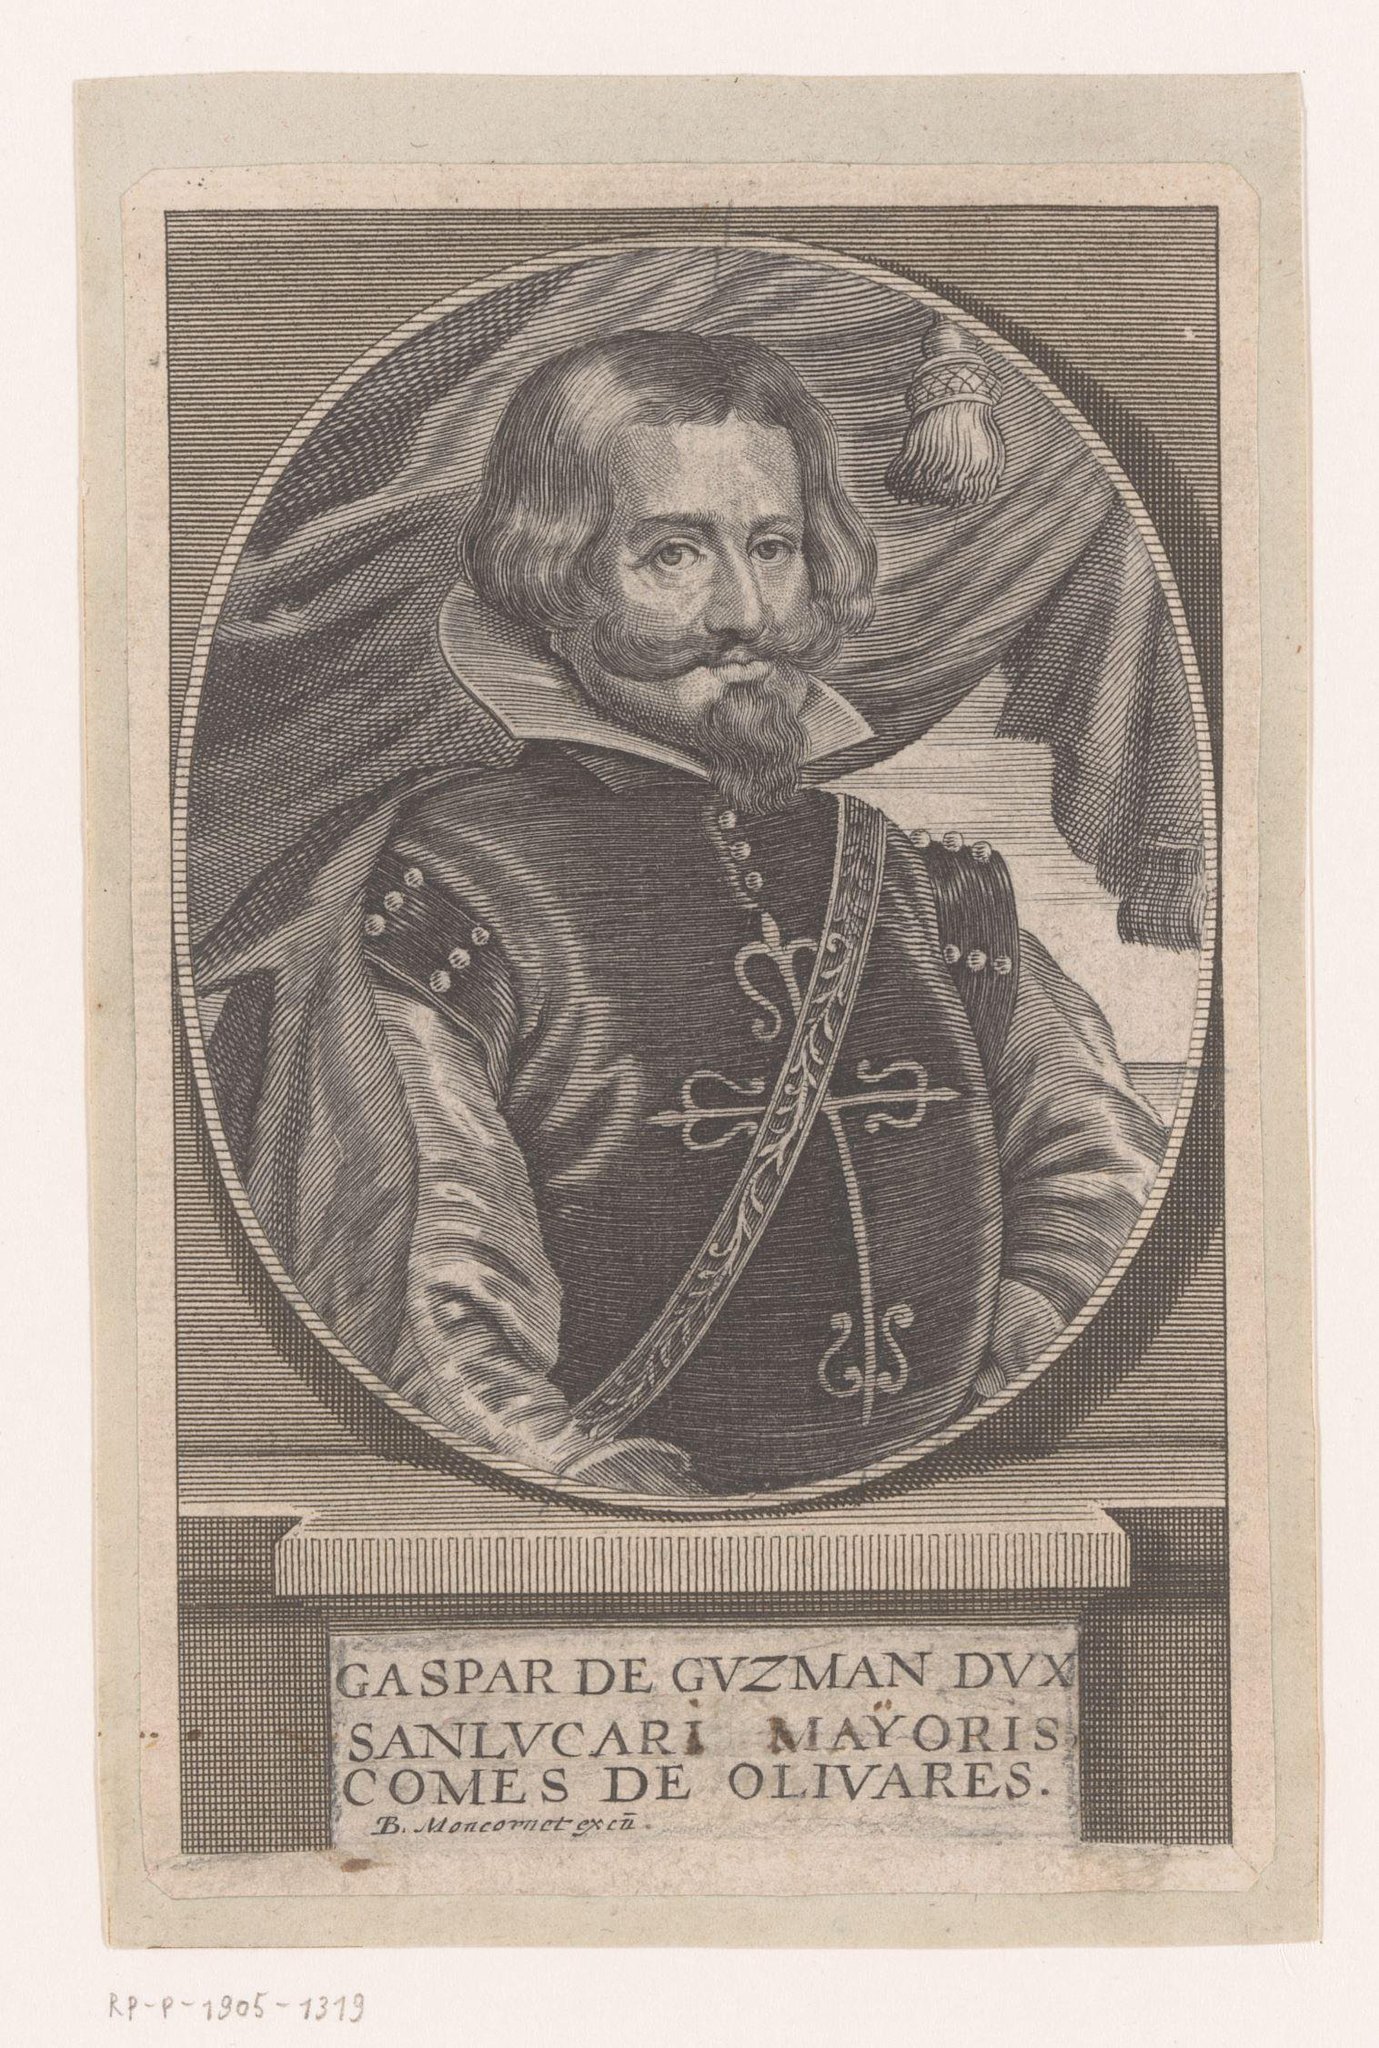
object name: print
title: Portret van Gaspar de Guzmán y Pimentel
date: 1620-1668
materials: paper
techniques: engraving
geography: paris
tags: historical persons, nobility and patriciate; chivalry, knighthood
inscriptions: collector's mark: Lugt 2228